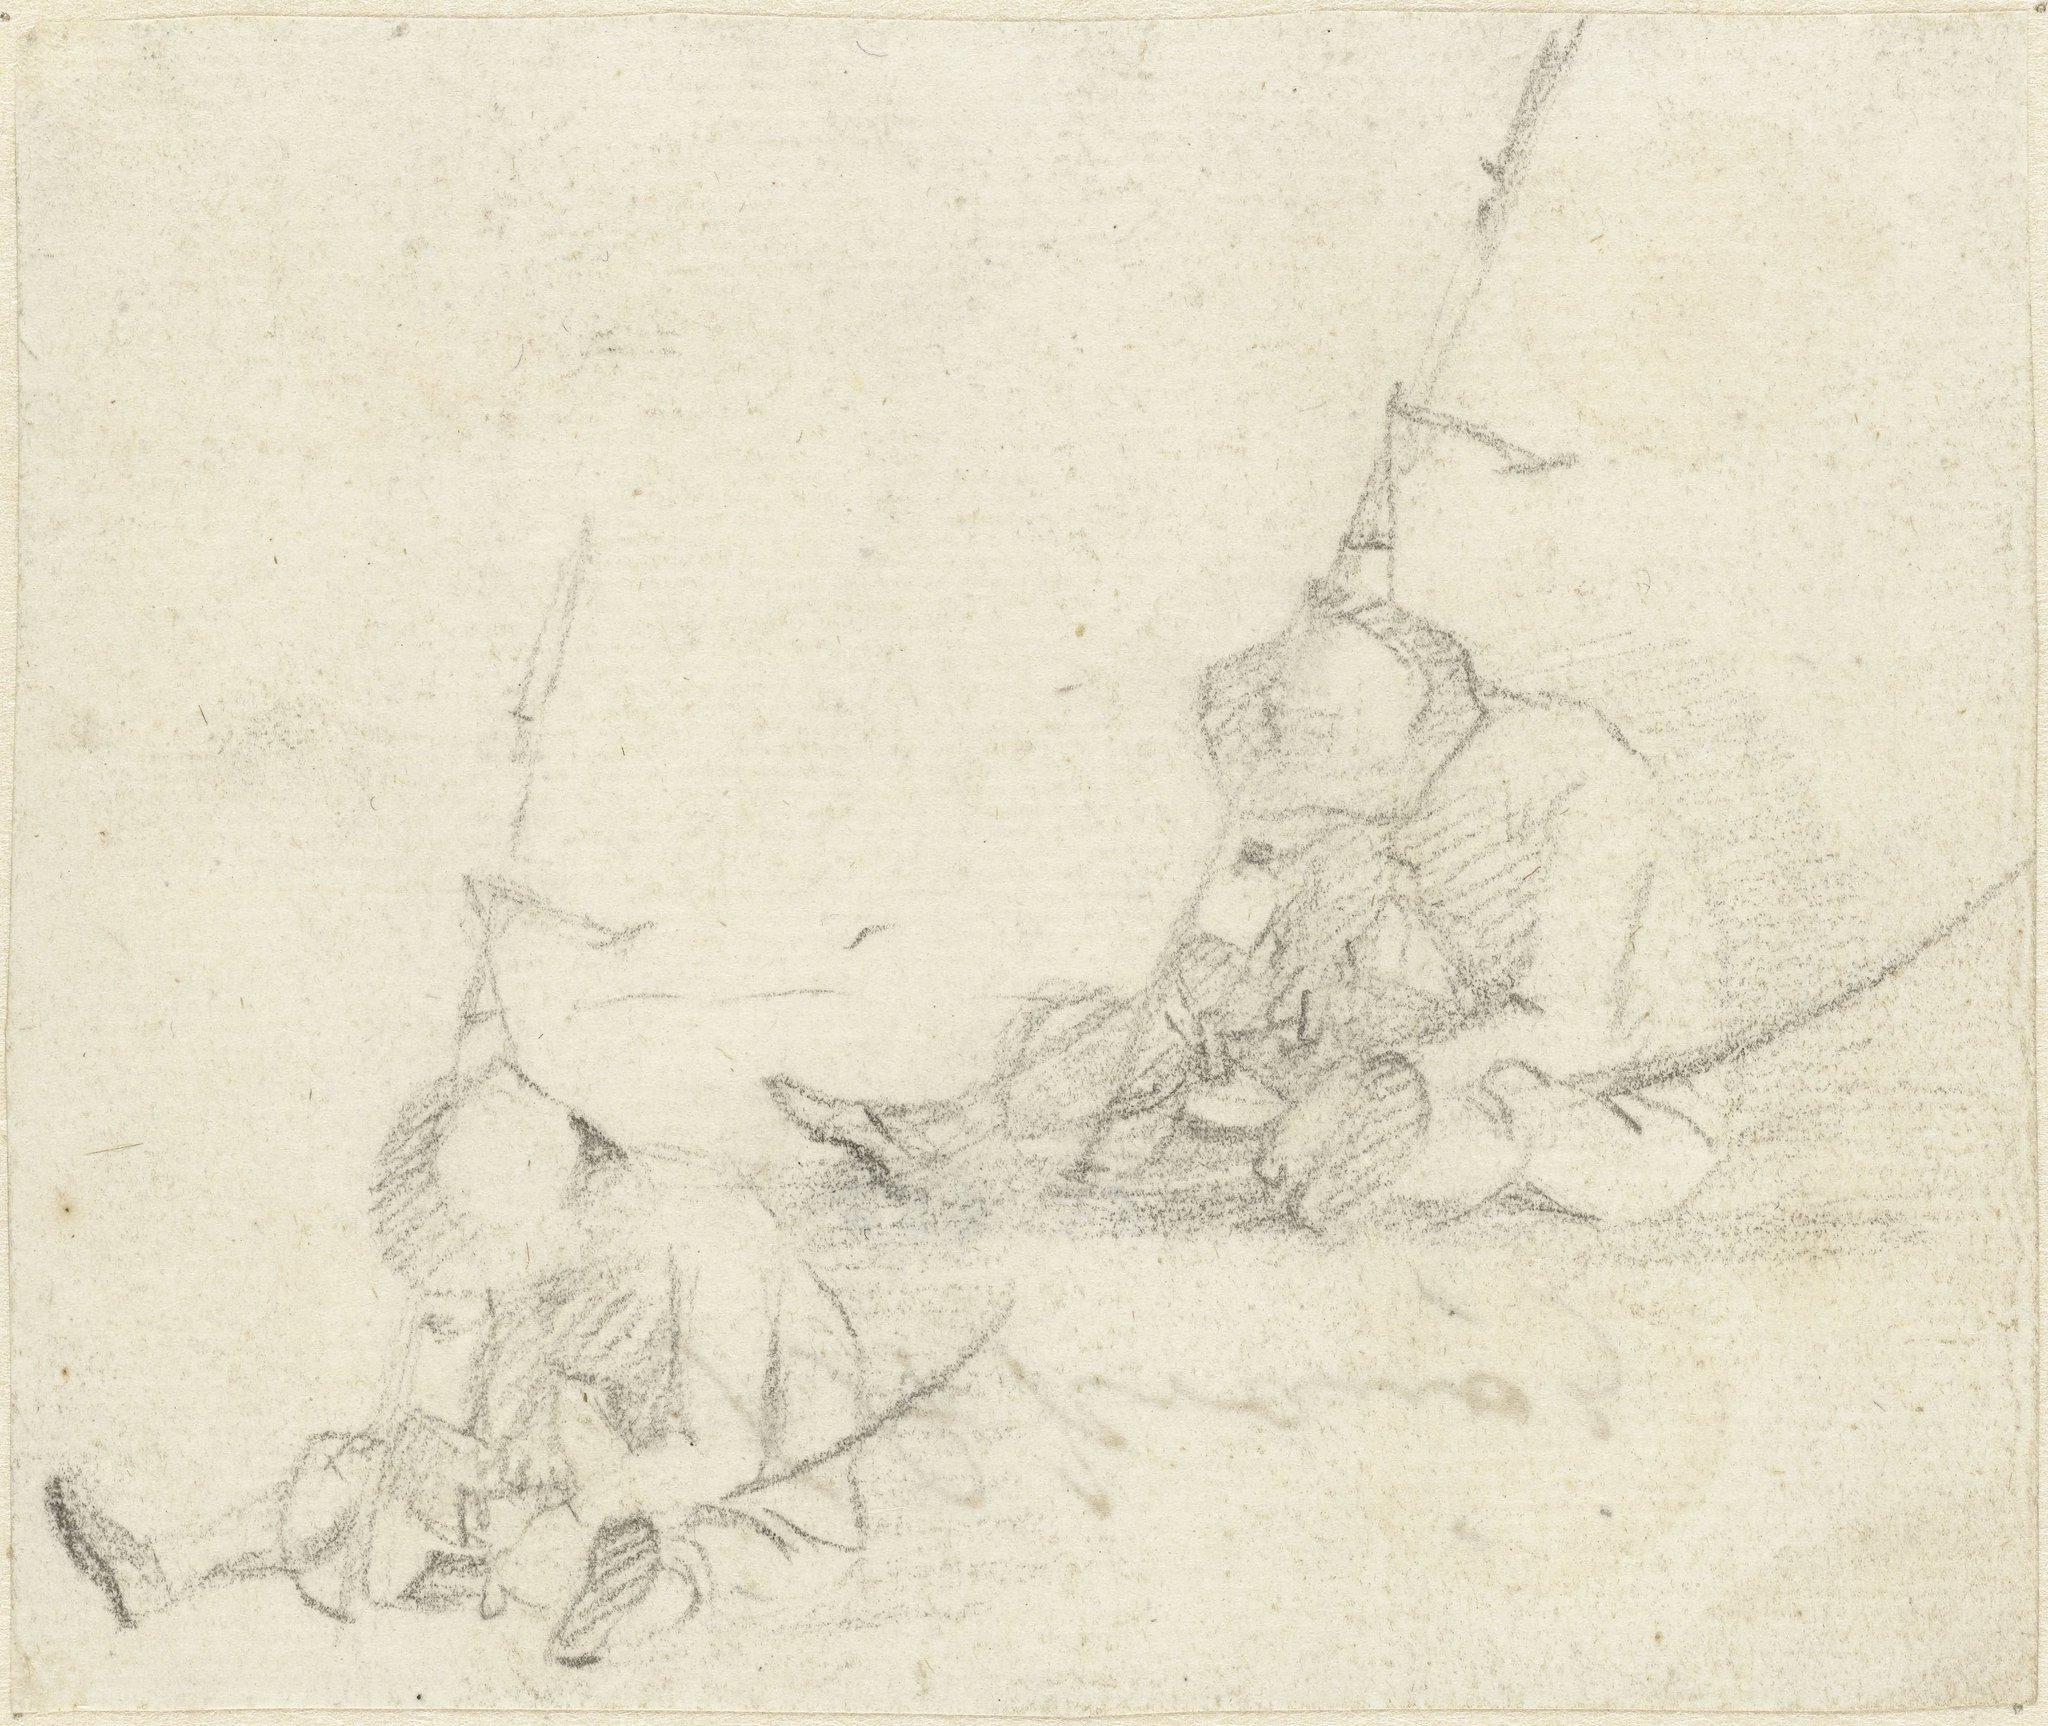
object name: drawing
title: Twee schetsen van een zittend figuur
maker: simon andreas krausz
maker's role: draughtsman, print maker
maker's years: 1760-1825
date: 1770-1825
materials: paper, pencil